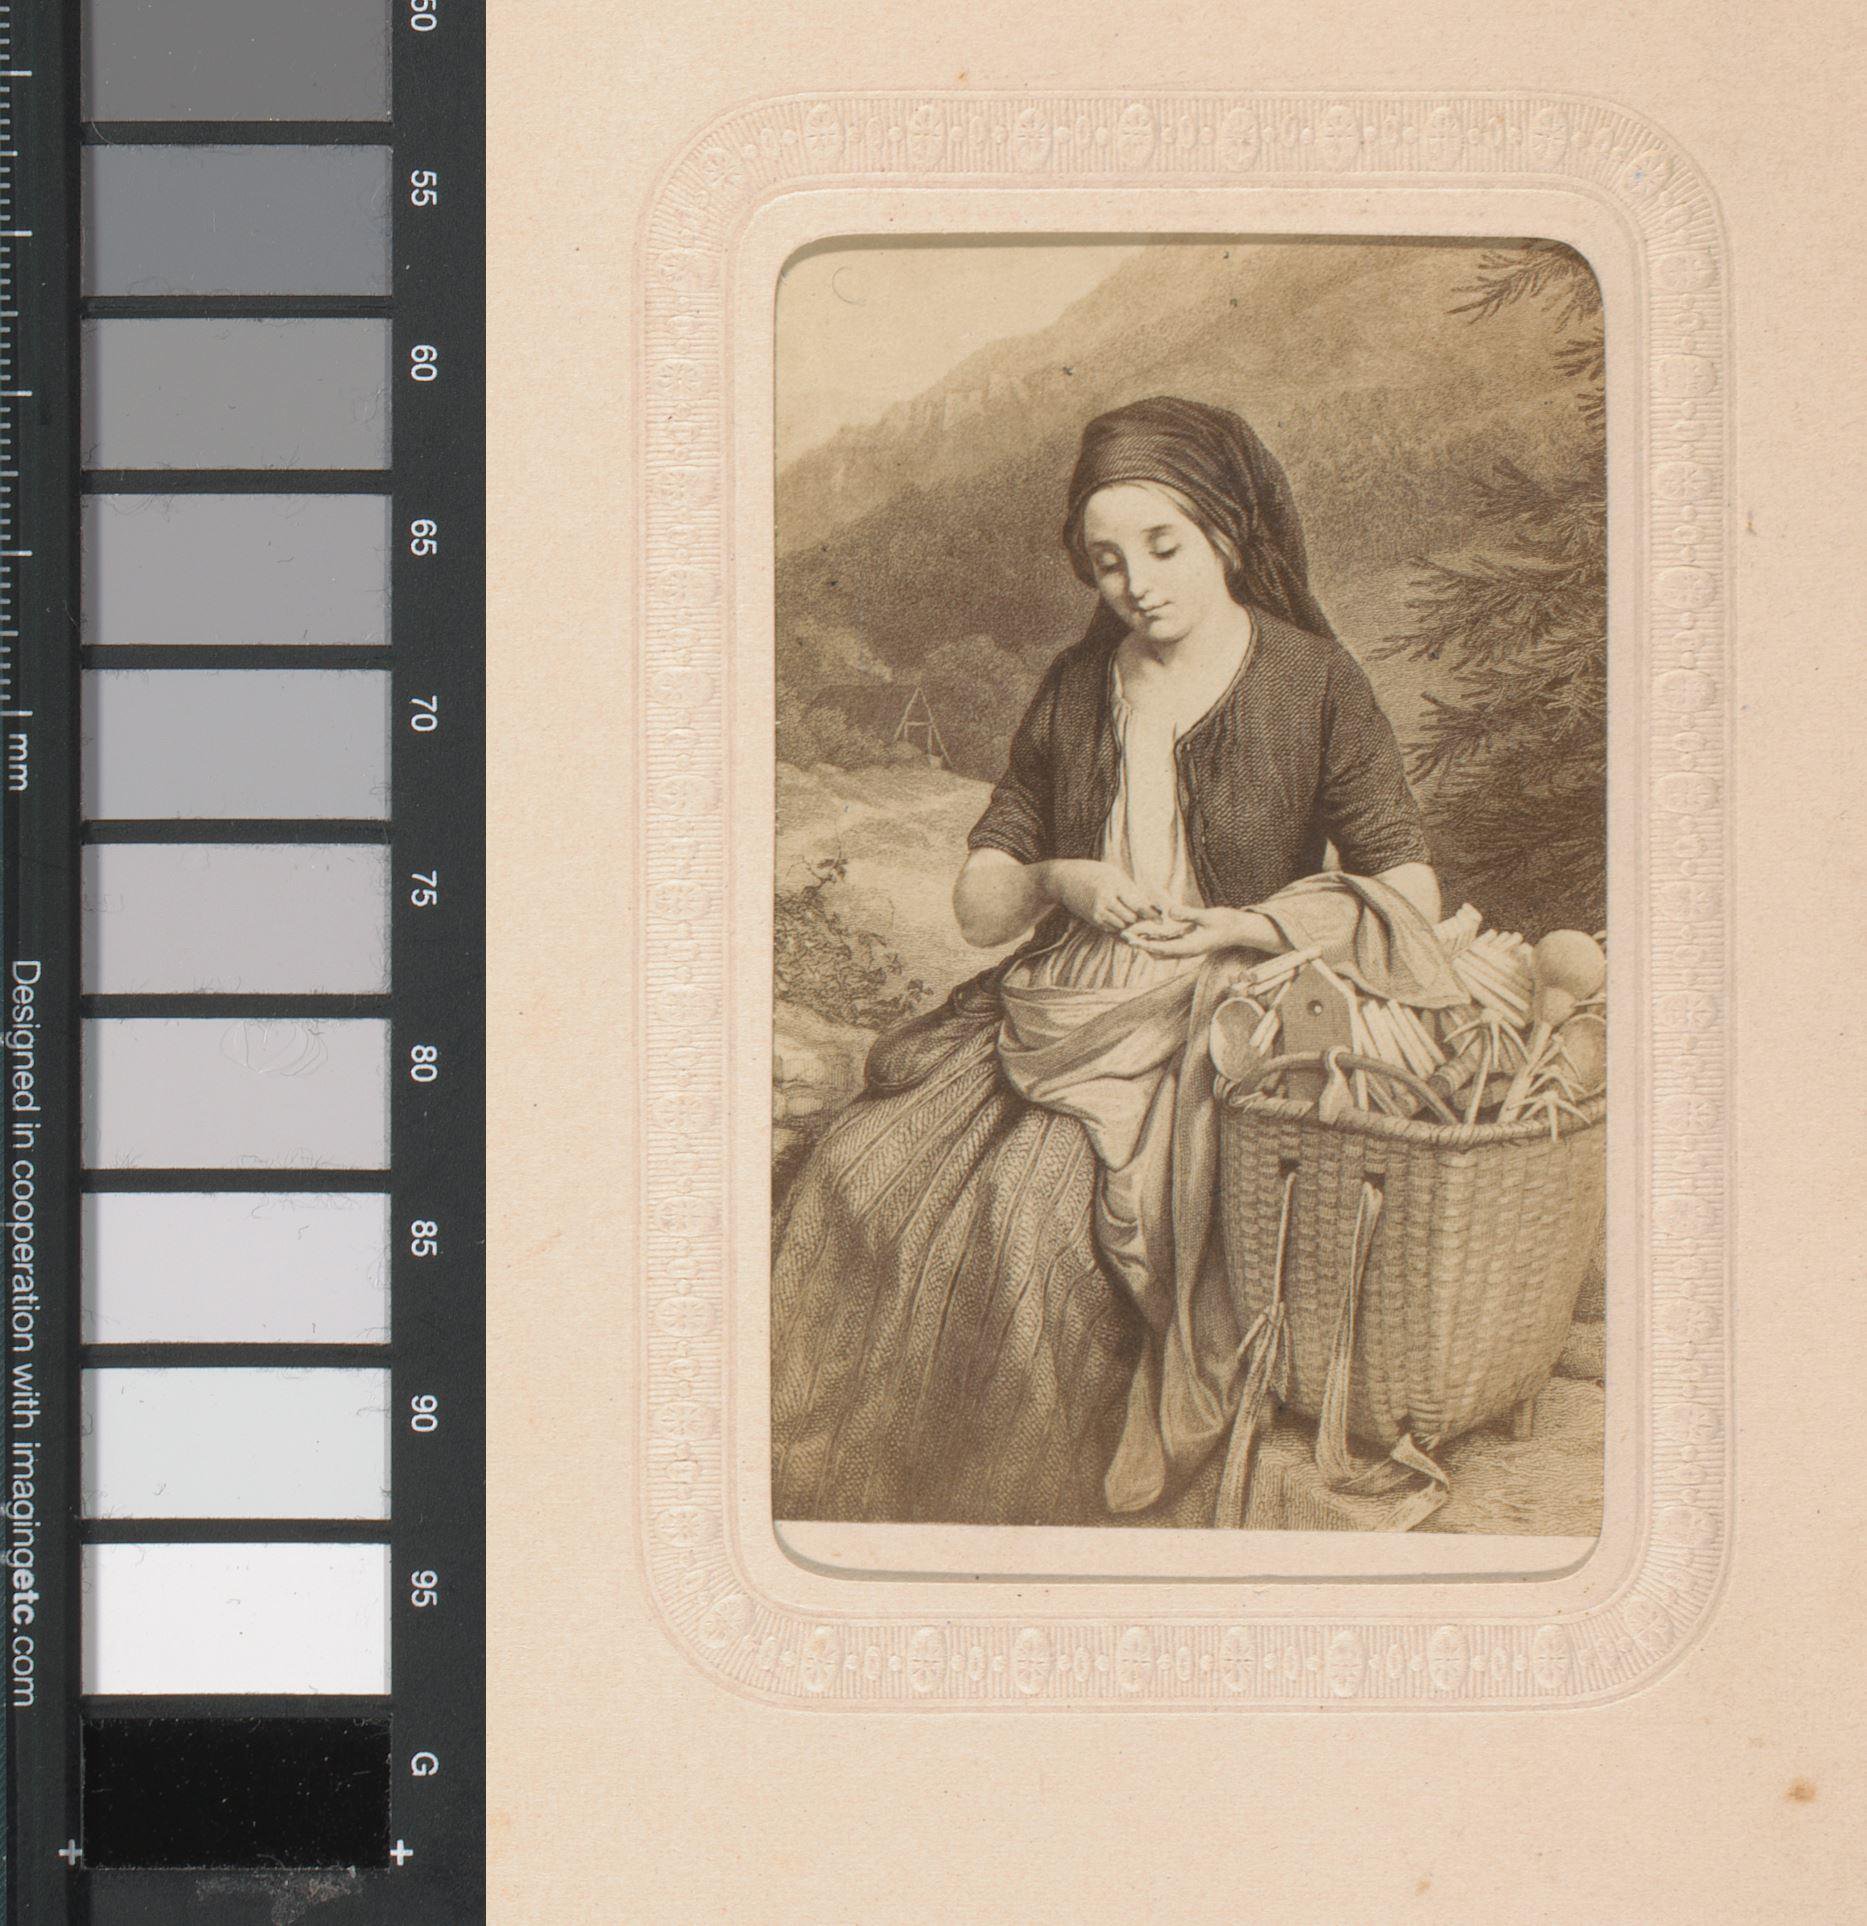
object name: carte de visite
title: Fotoreproductie van een schilderij van een zittende vrouw met een mand vol spullen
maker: Anonymous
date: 1855-1865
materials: cardboard, photographic support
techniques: albumen print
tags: carrying something in basket, bag, rucksack, etc., sitting on an elevation - aa - female human figure